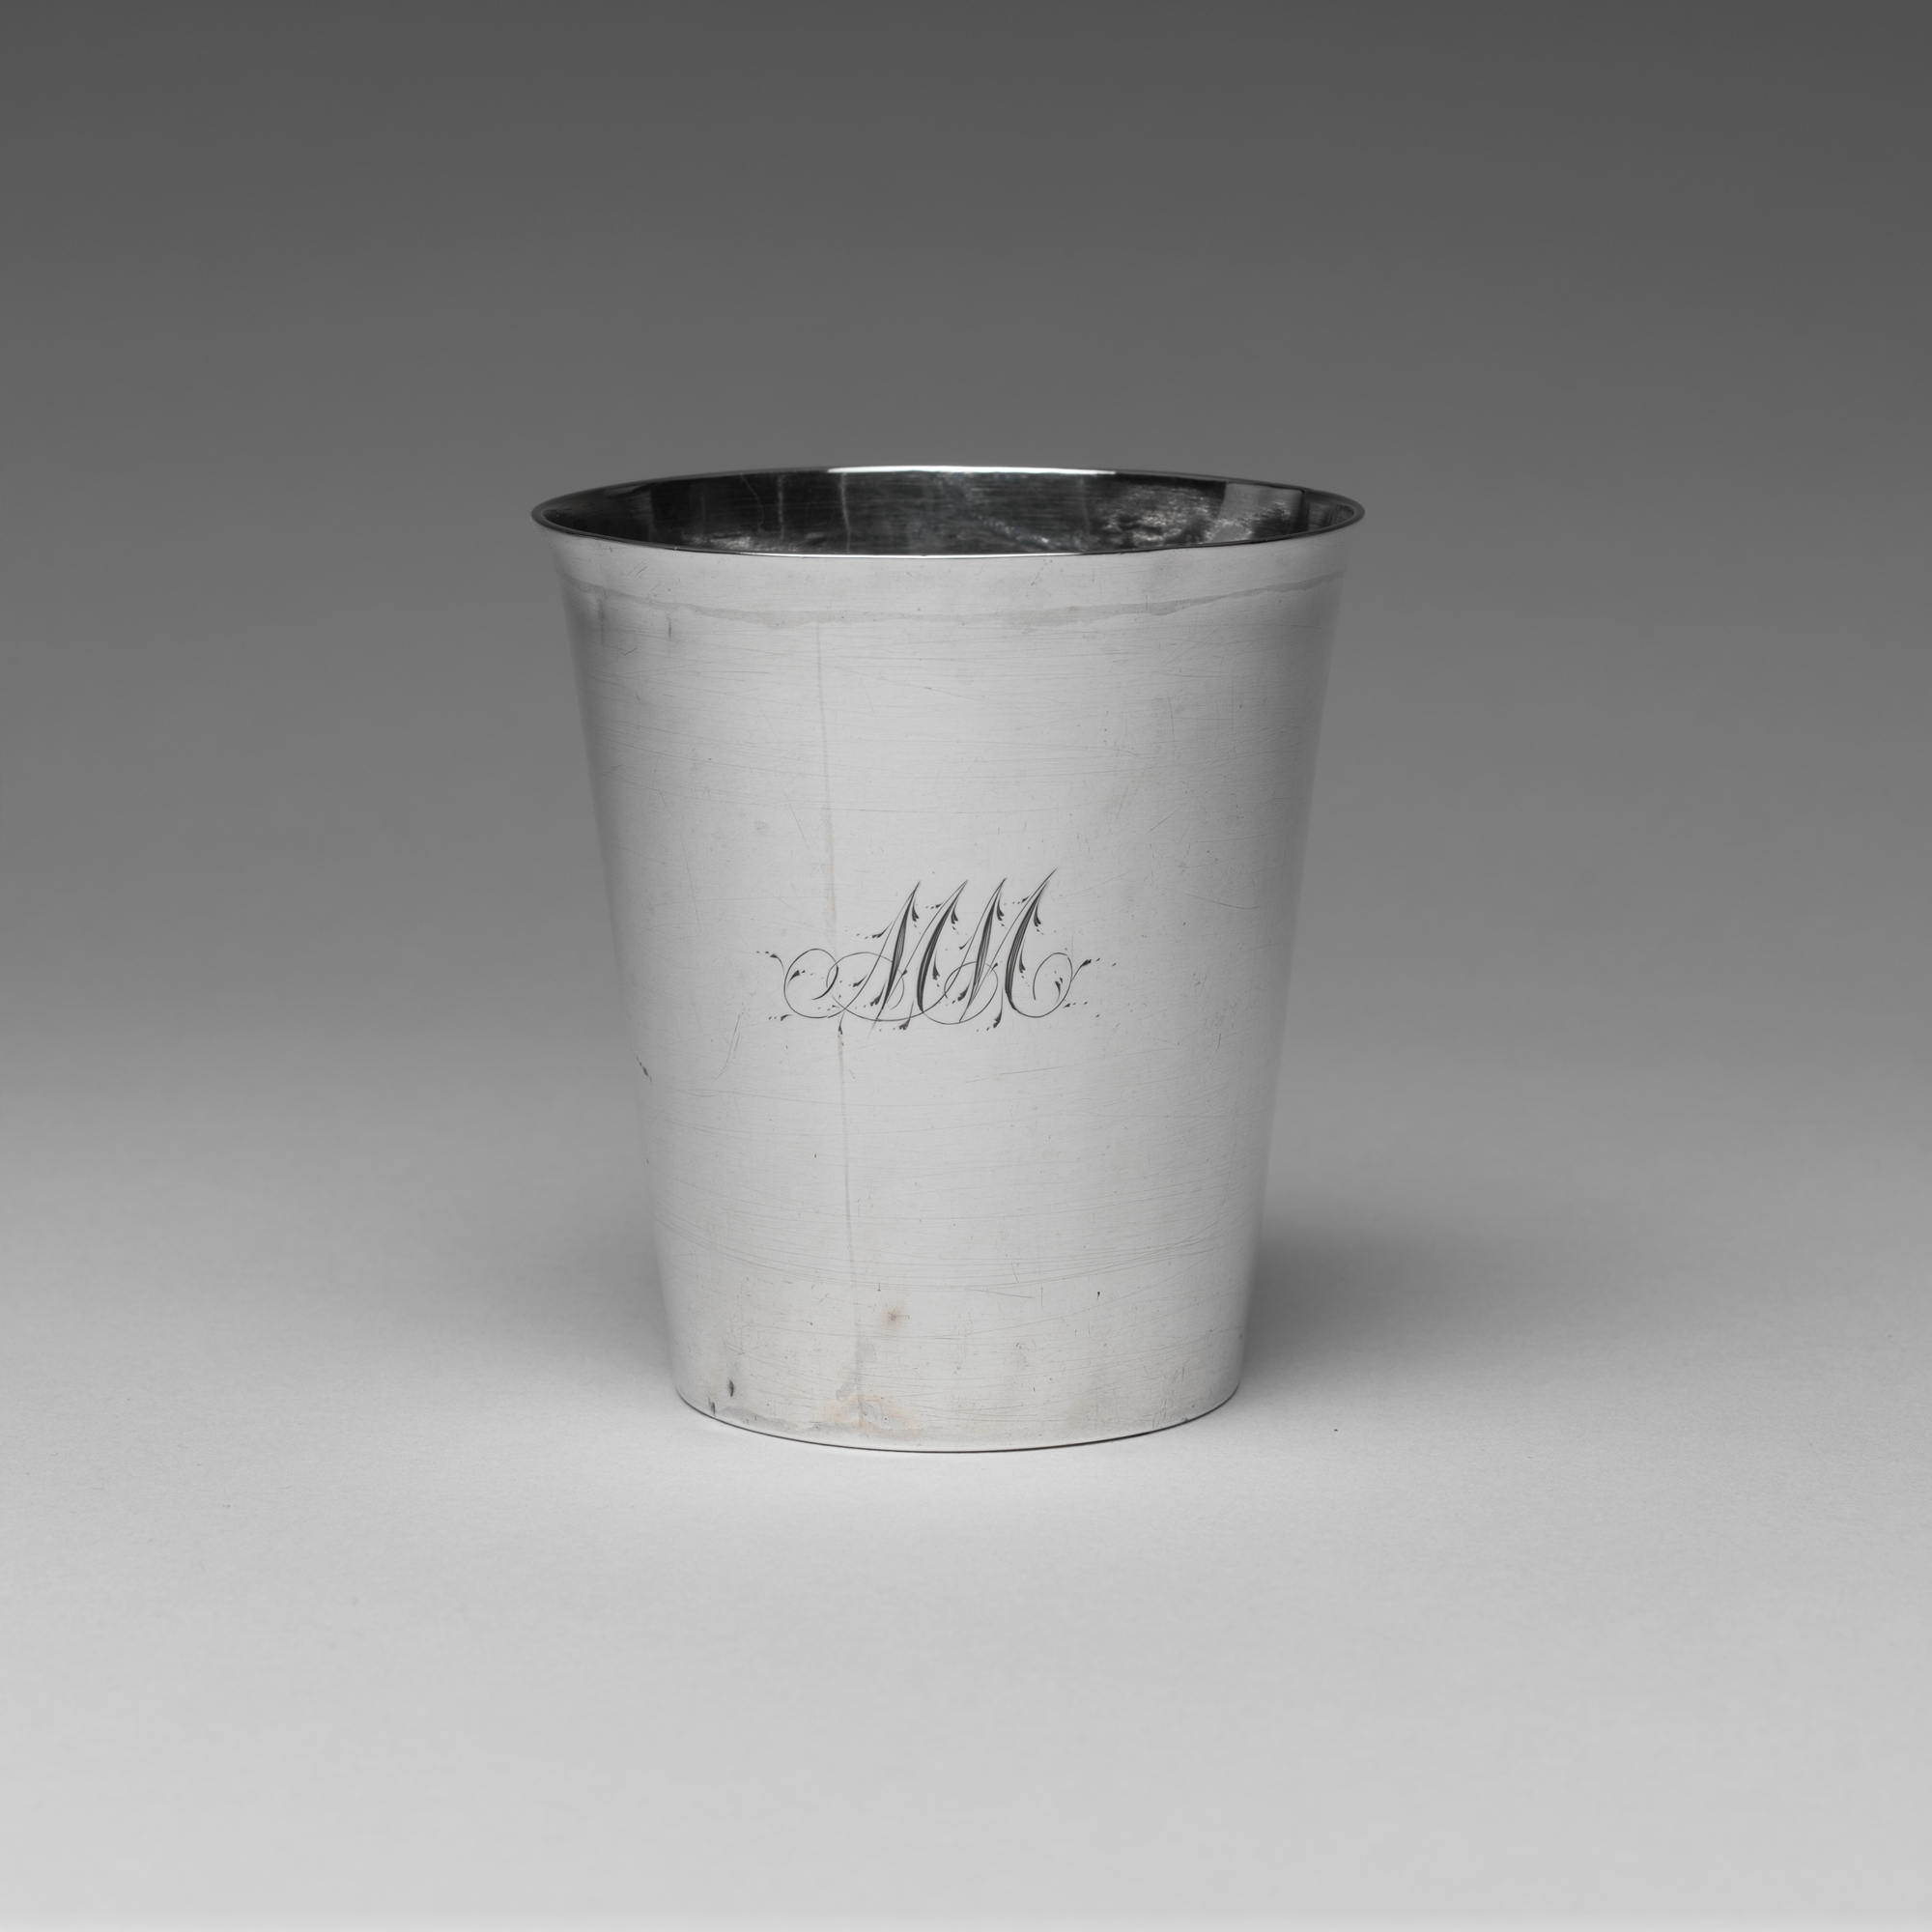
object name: beaker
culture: american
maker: samuel drowne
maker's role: maker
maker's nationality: american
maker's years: 1749-1815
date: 1770-1800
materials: silver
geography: united states